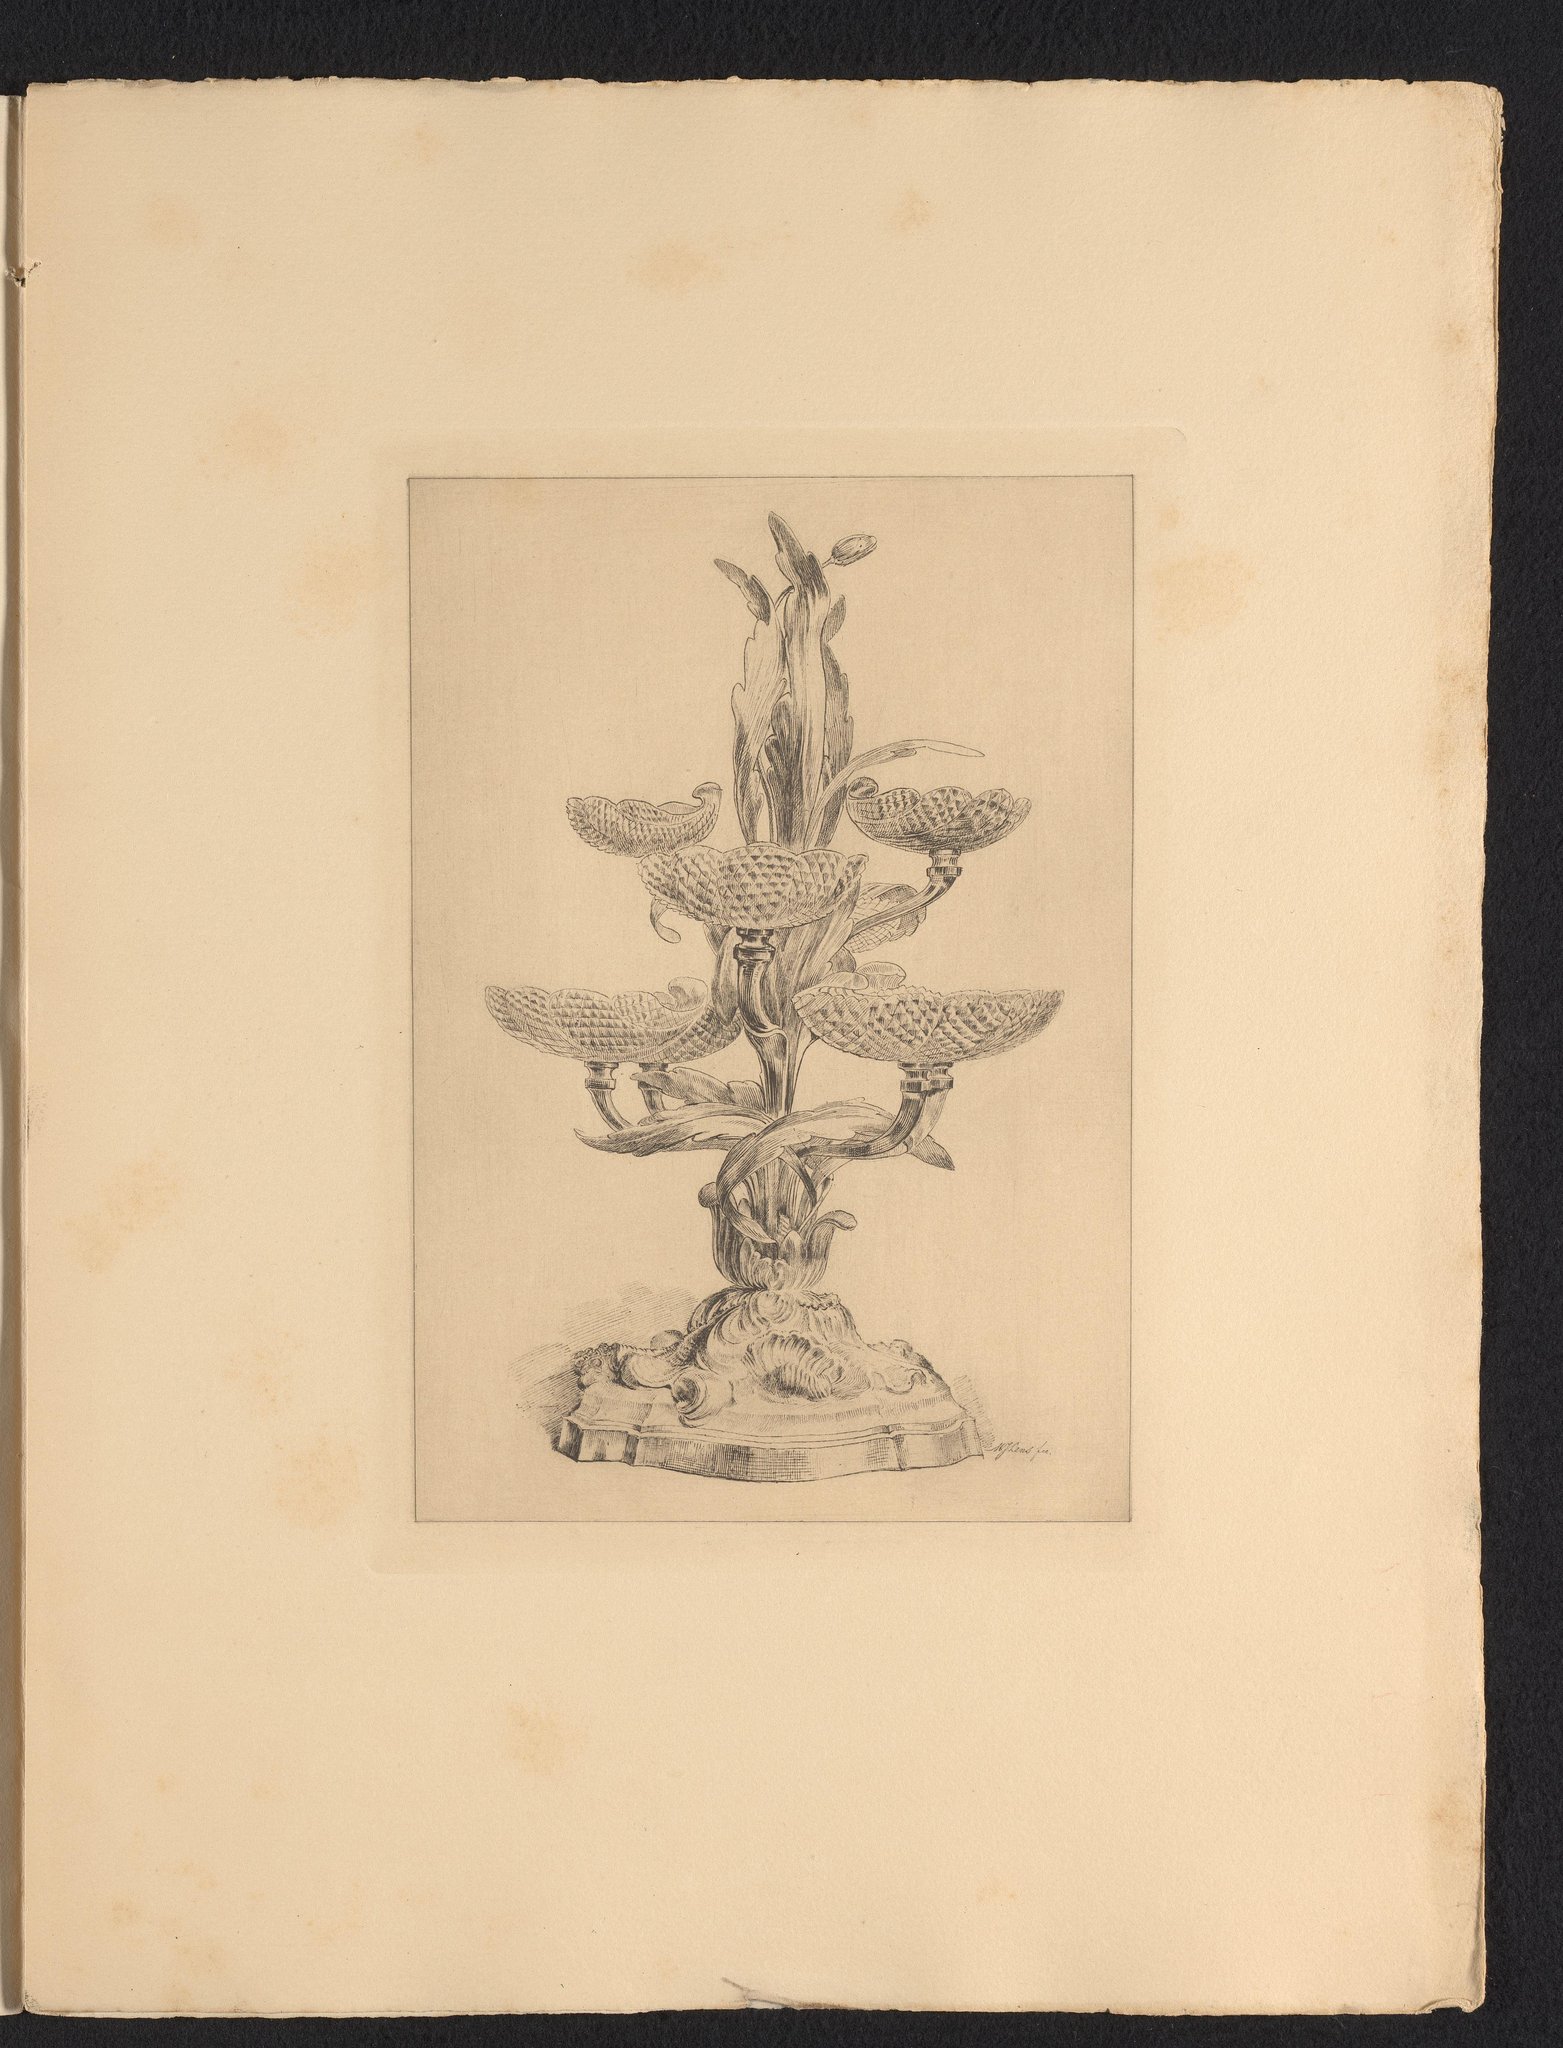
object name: print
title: Zilveren bonbonnière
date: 1889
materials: paper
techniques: etching, intaglio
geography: utrecht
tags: serving-dish, platter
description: Prent maakt deel uit van een serie van veertien prenten.